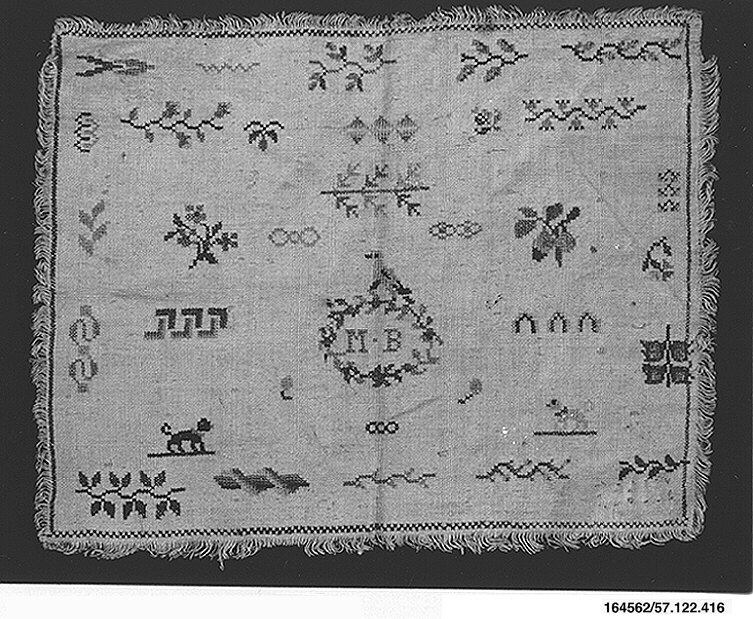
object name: sampler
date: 1801-1900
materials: linen, silk